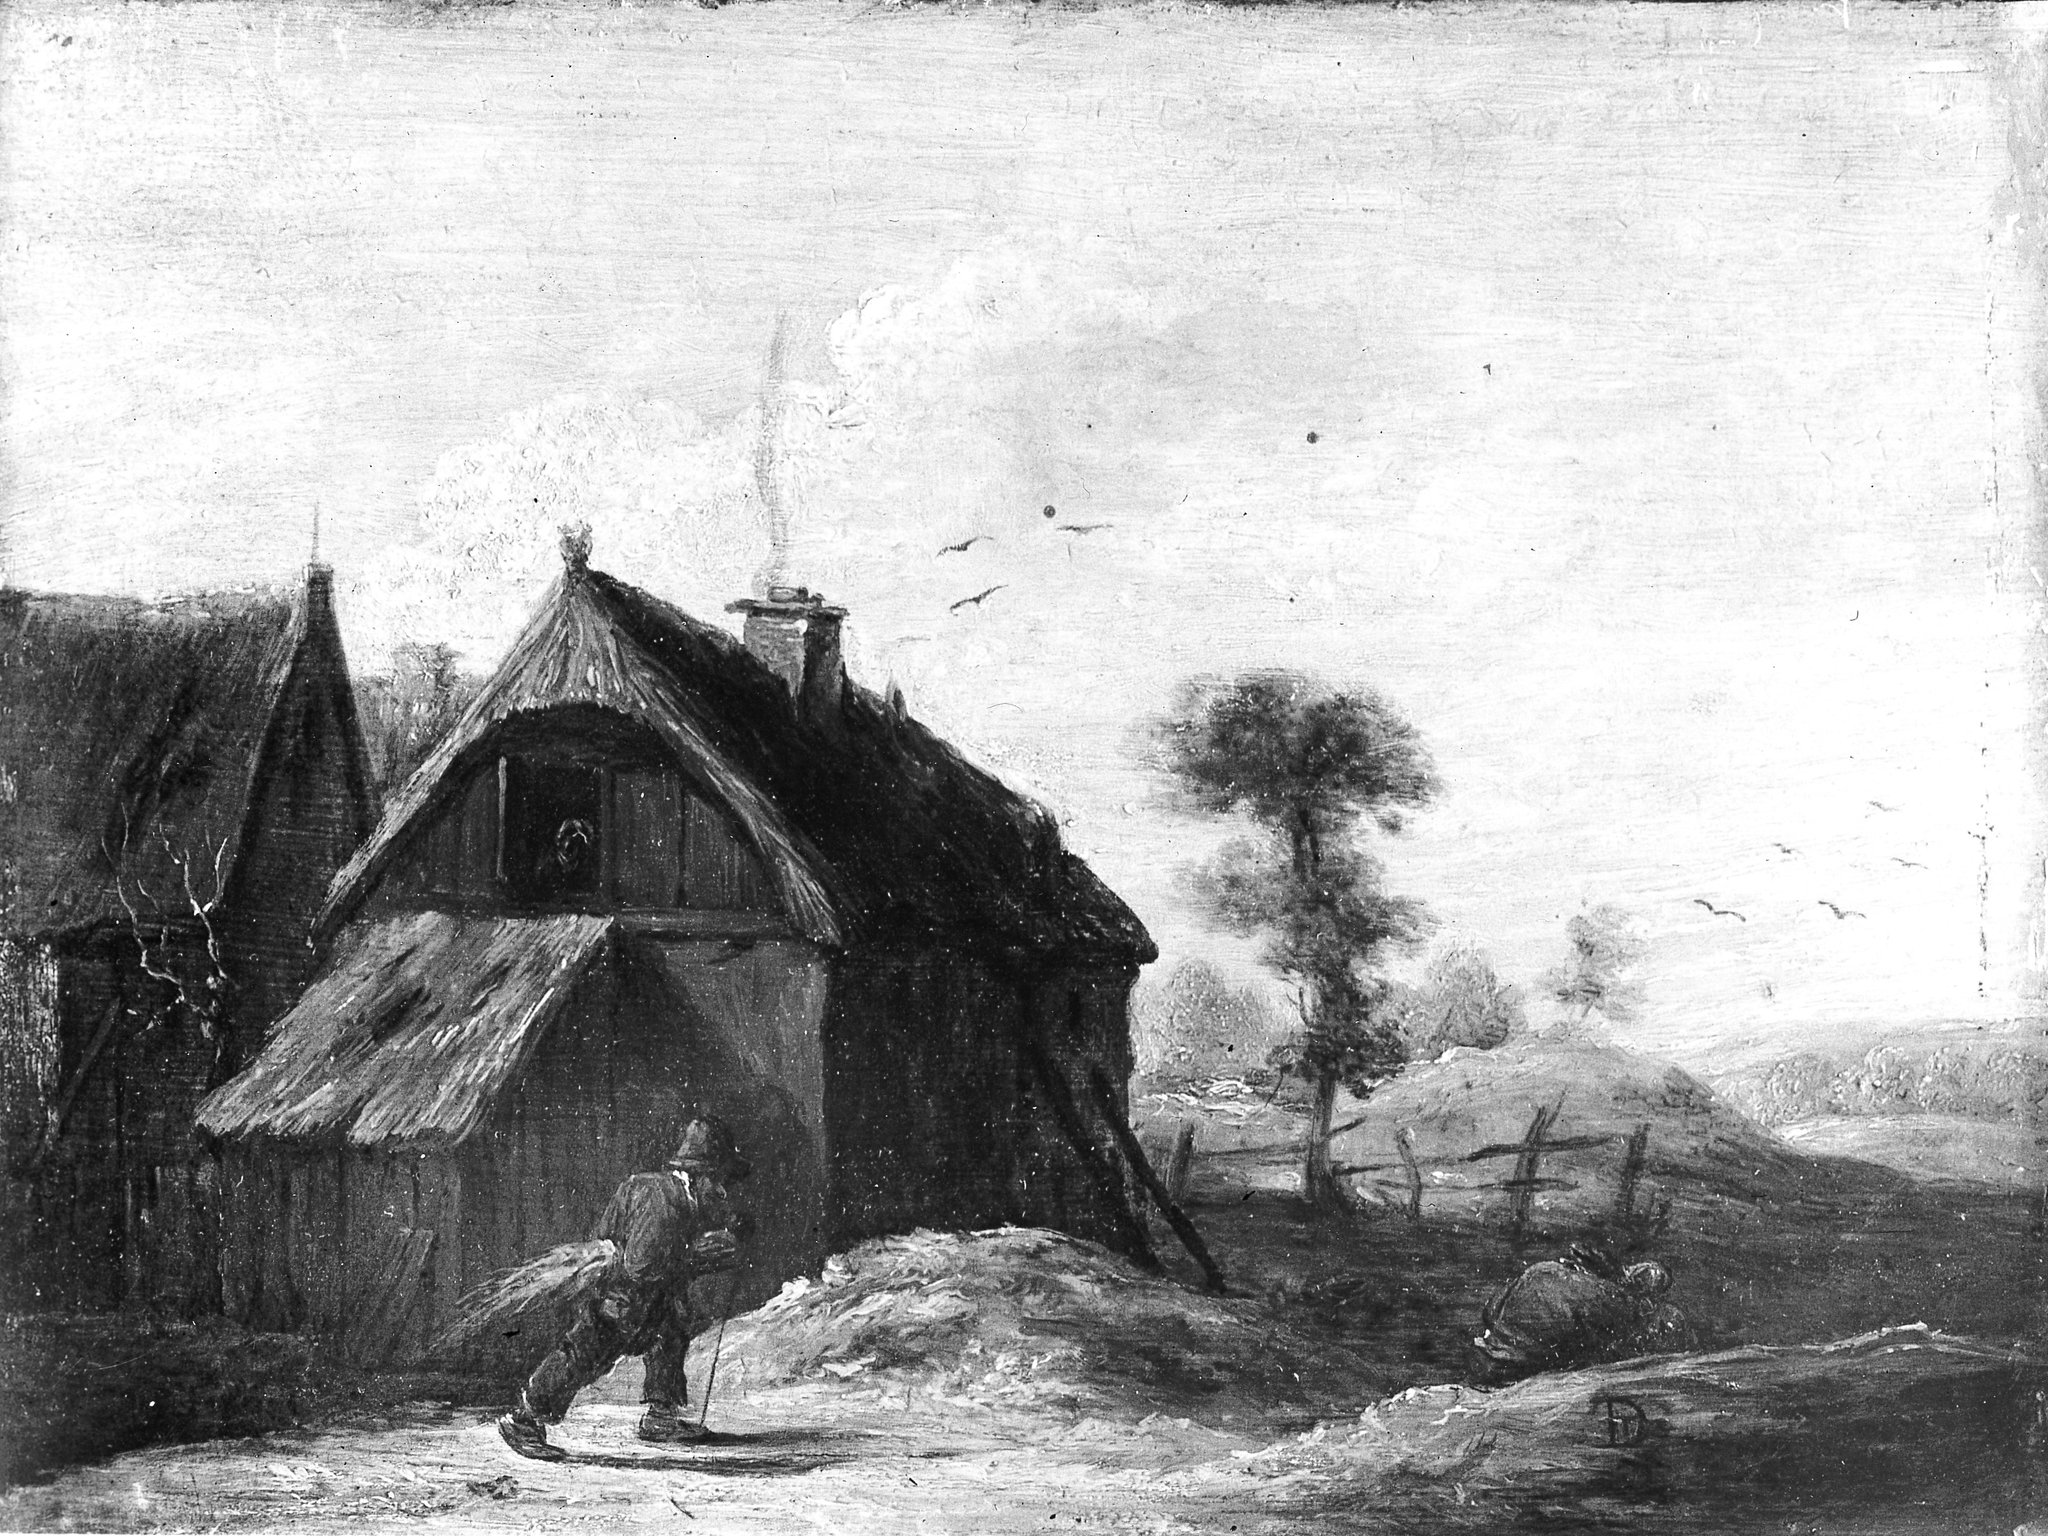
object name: painting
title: Landscape with Thatched Cottages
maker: david teniers the younger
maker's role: artist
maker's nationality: flemish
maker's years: 1610-1690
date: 1630-1690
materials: oil, wood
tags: men,landscapes